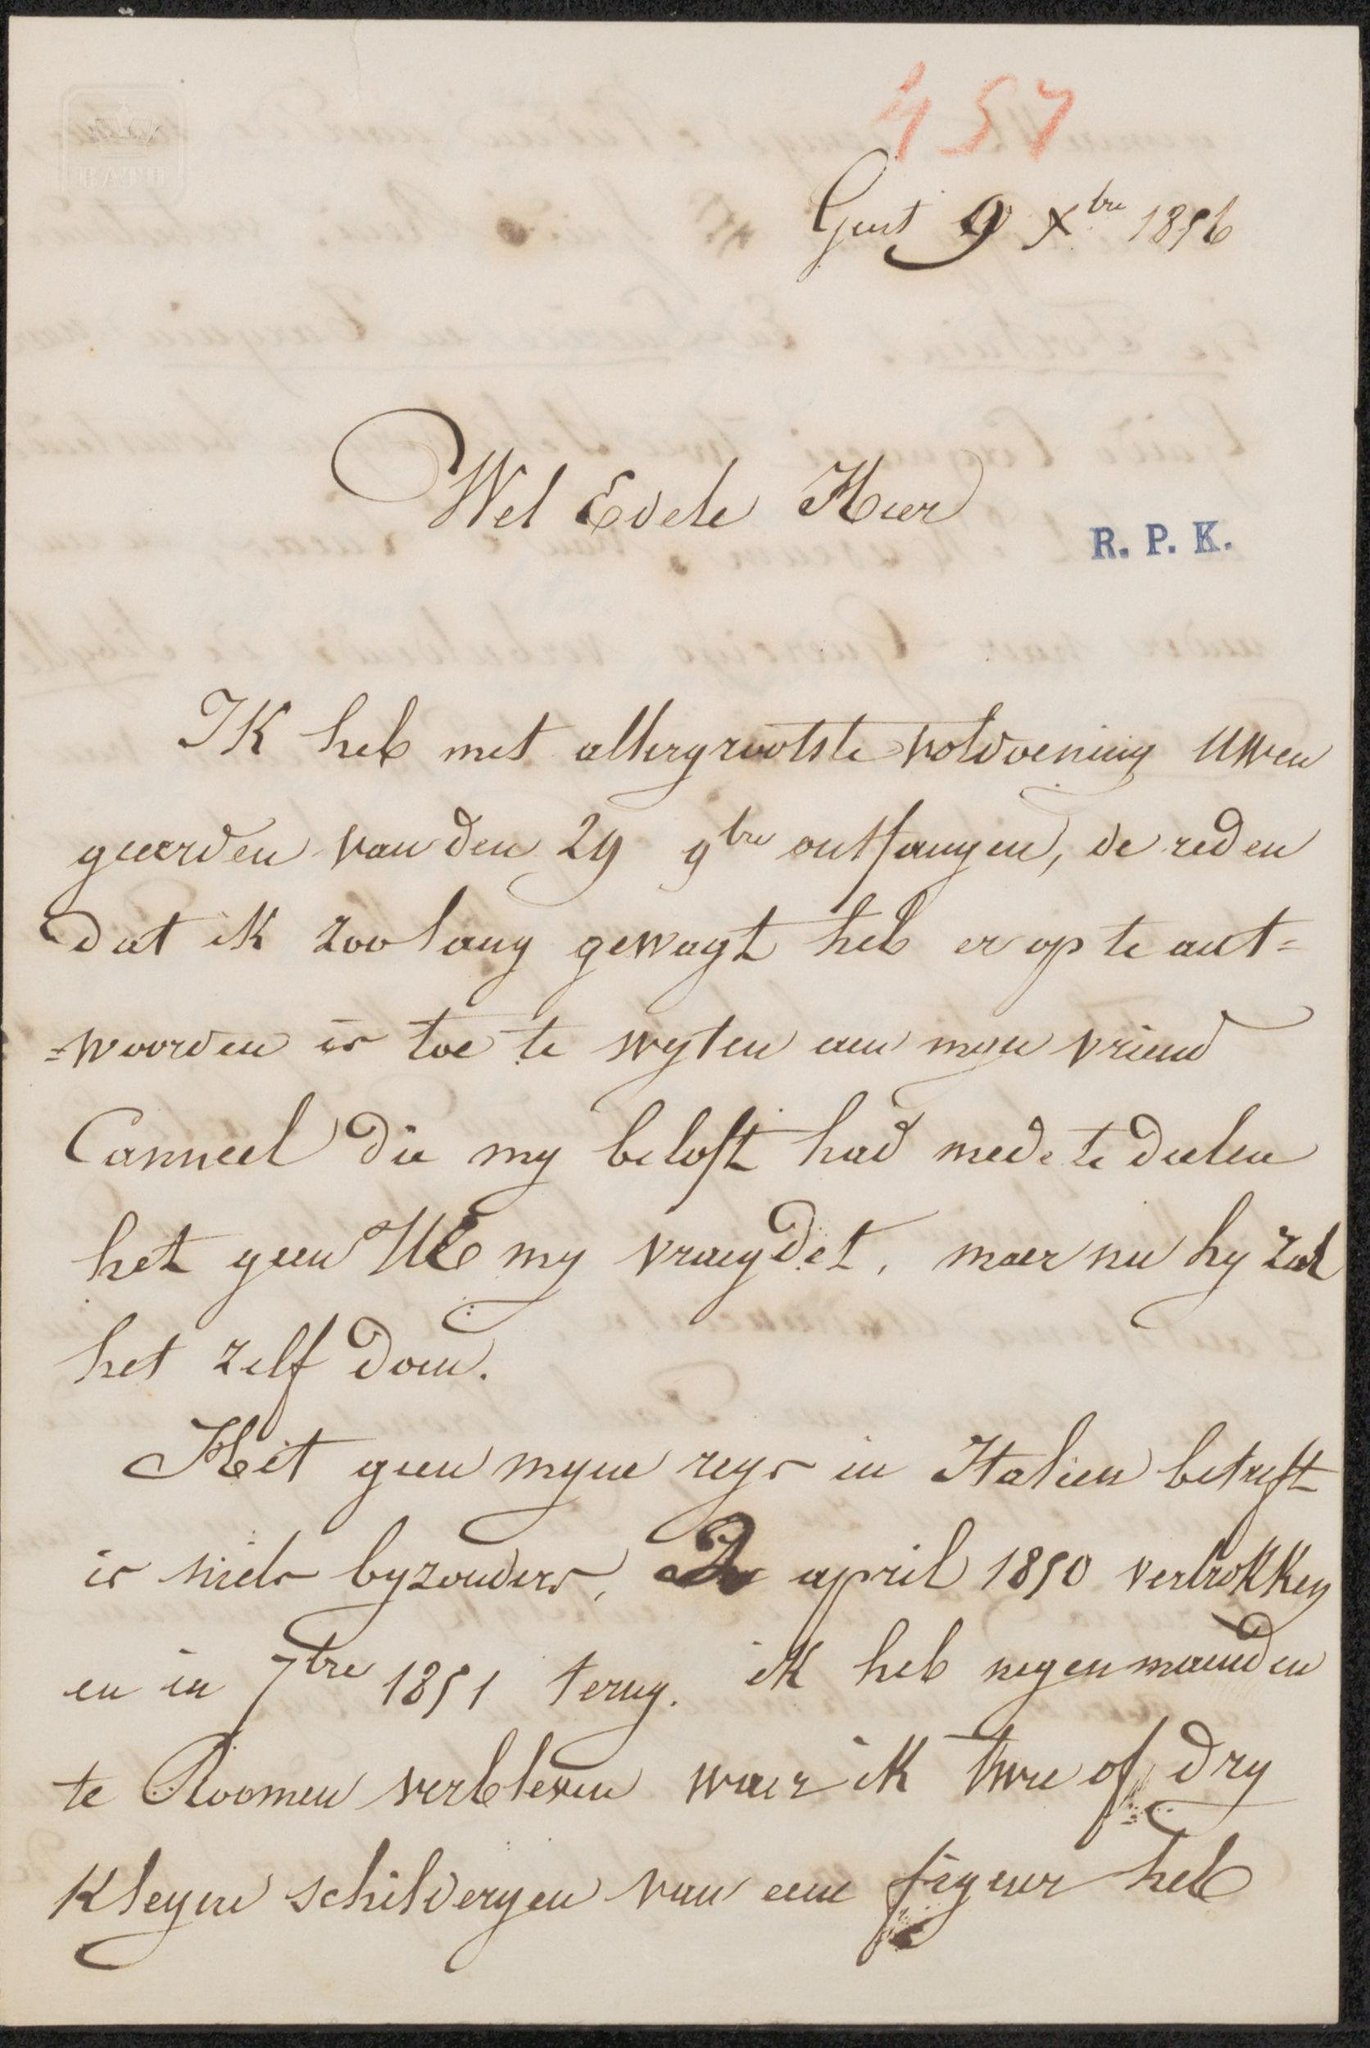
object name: letter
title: Brief aan Christiaan Kramm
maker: jacobus ludovicus godinau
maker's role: draughtsman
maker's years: 1811-1873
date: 1856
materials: ink, paper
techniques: pen, writing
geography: ghent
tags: guercino, painter, guido reni, ghent, théodore joseph canneel, utrecht, print maker, draughtsman, christiaan kramm, drawing, travelling; tourism, painting (including book-illumination, miniature-painting), workshop, studio of the artist (in general), exhibition ~ art, italy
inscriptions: collector's mark: Lugt 2233